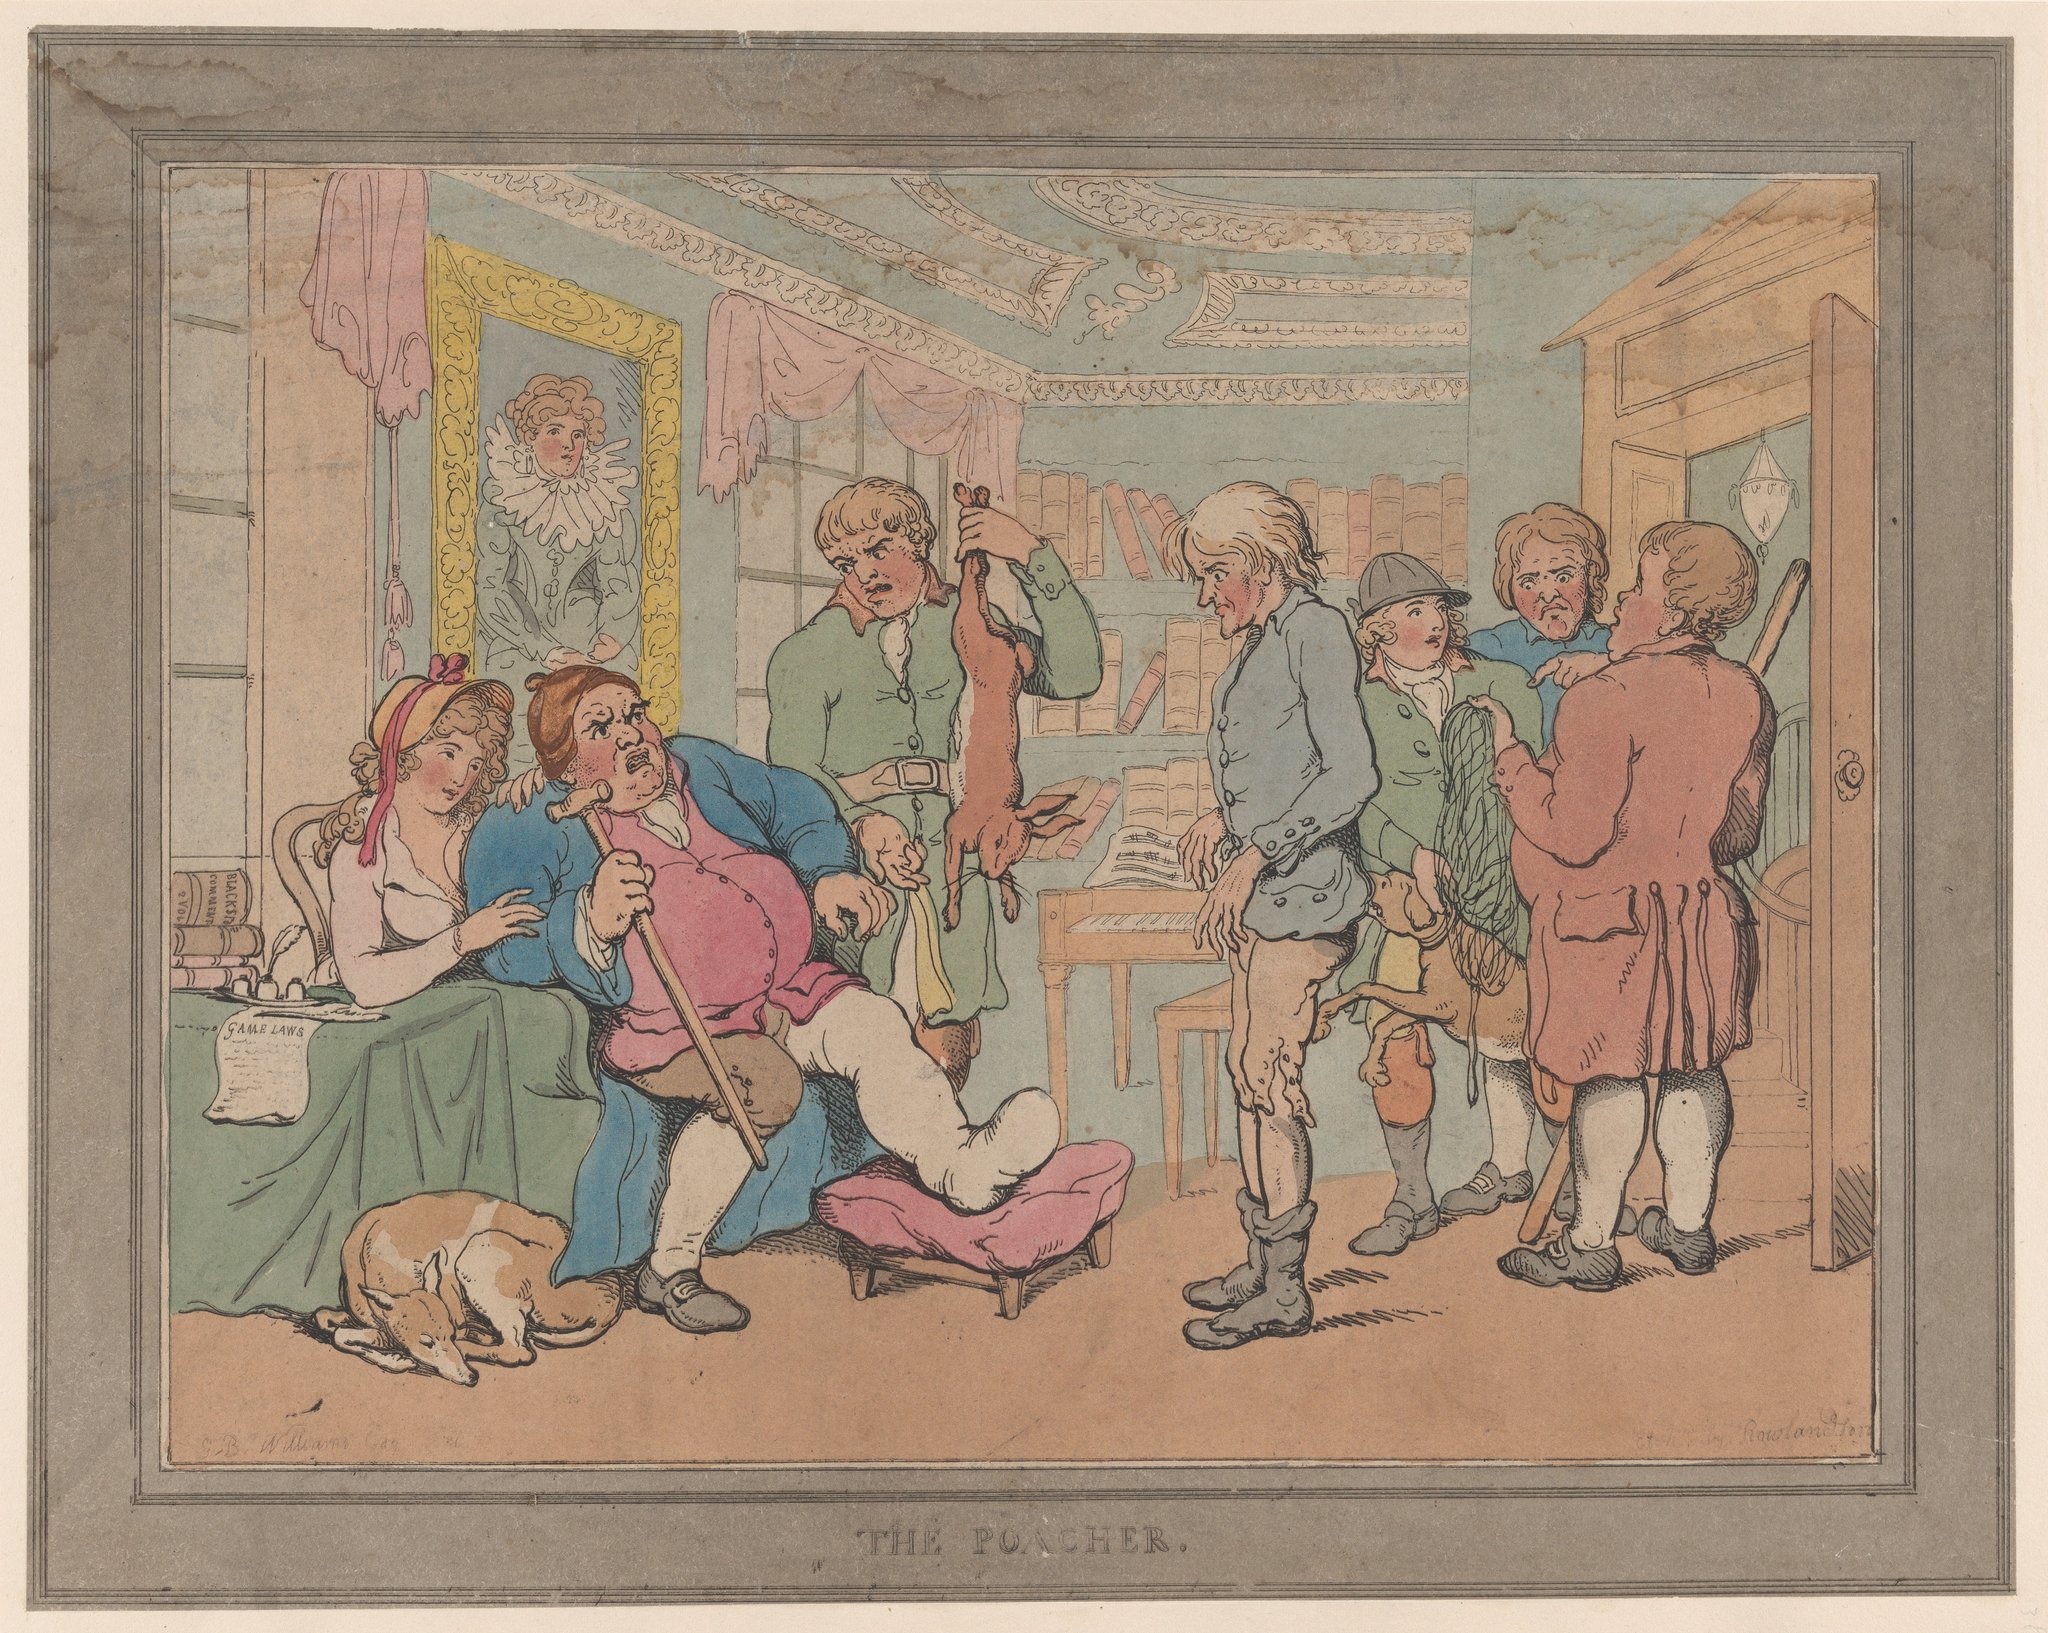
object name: print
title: The Poacher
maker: thomas rowlandson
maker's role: artist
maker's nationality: british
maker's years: 1757-1827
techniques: etching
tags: satire,men,women,dogs,rabbits